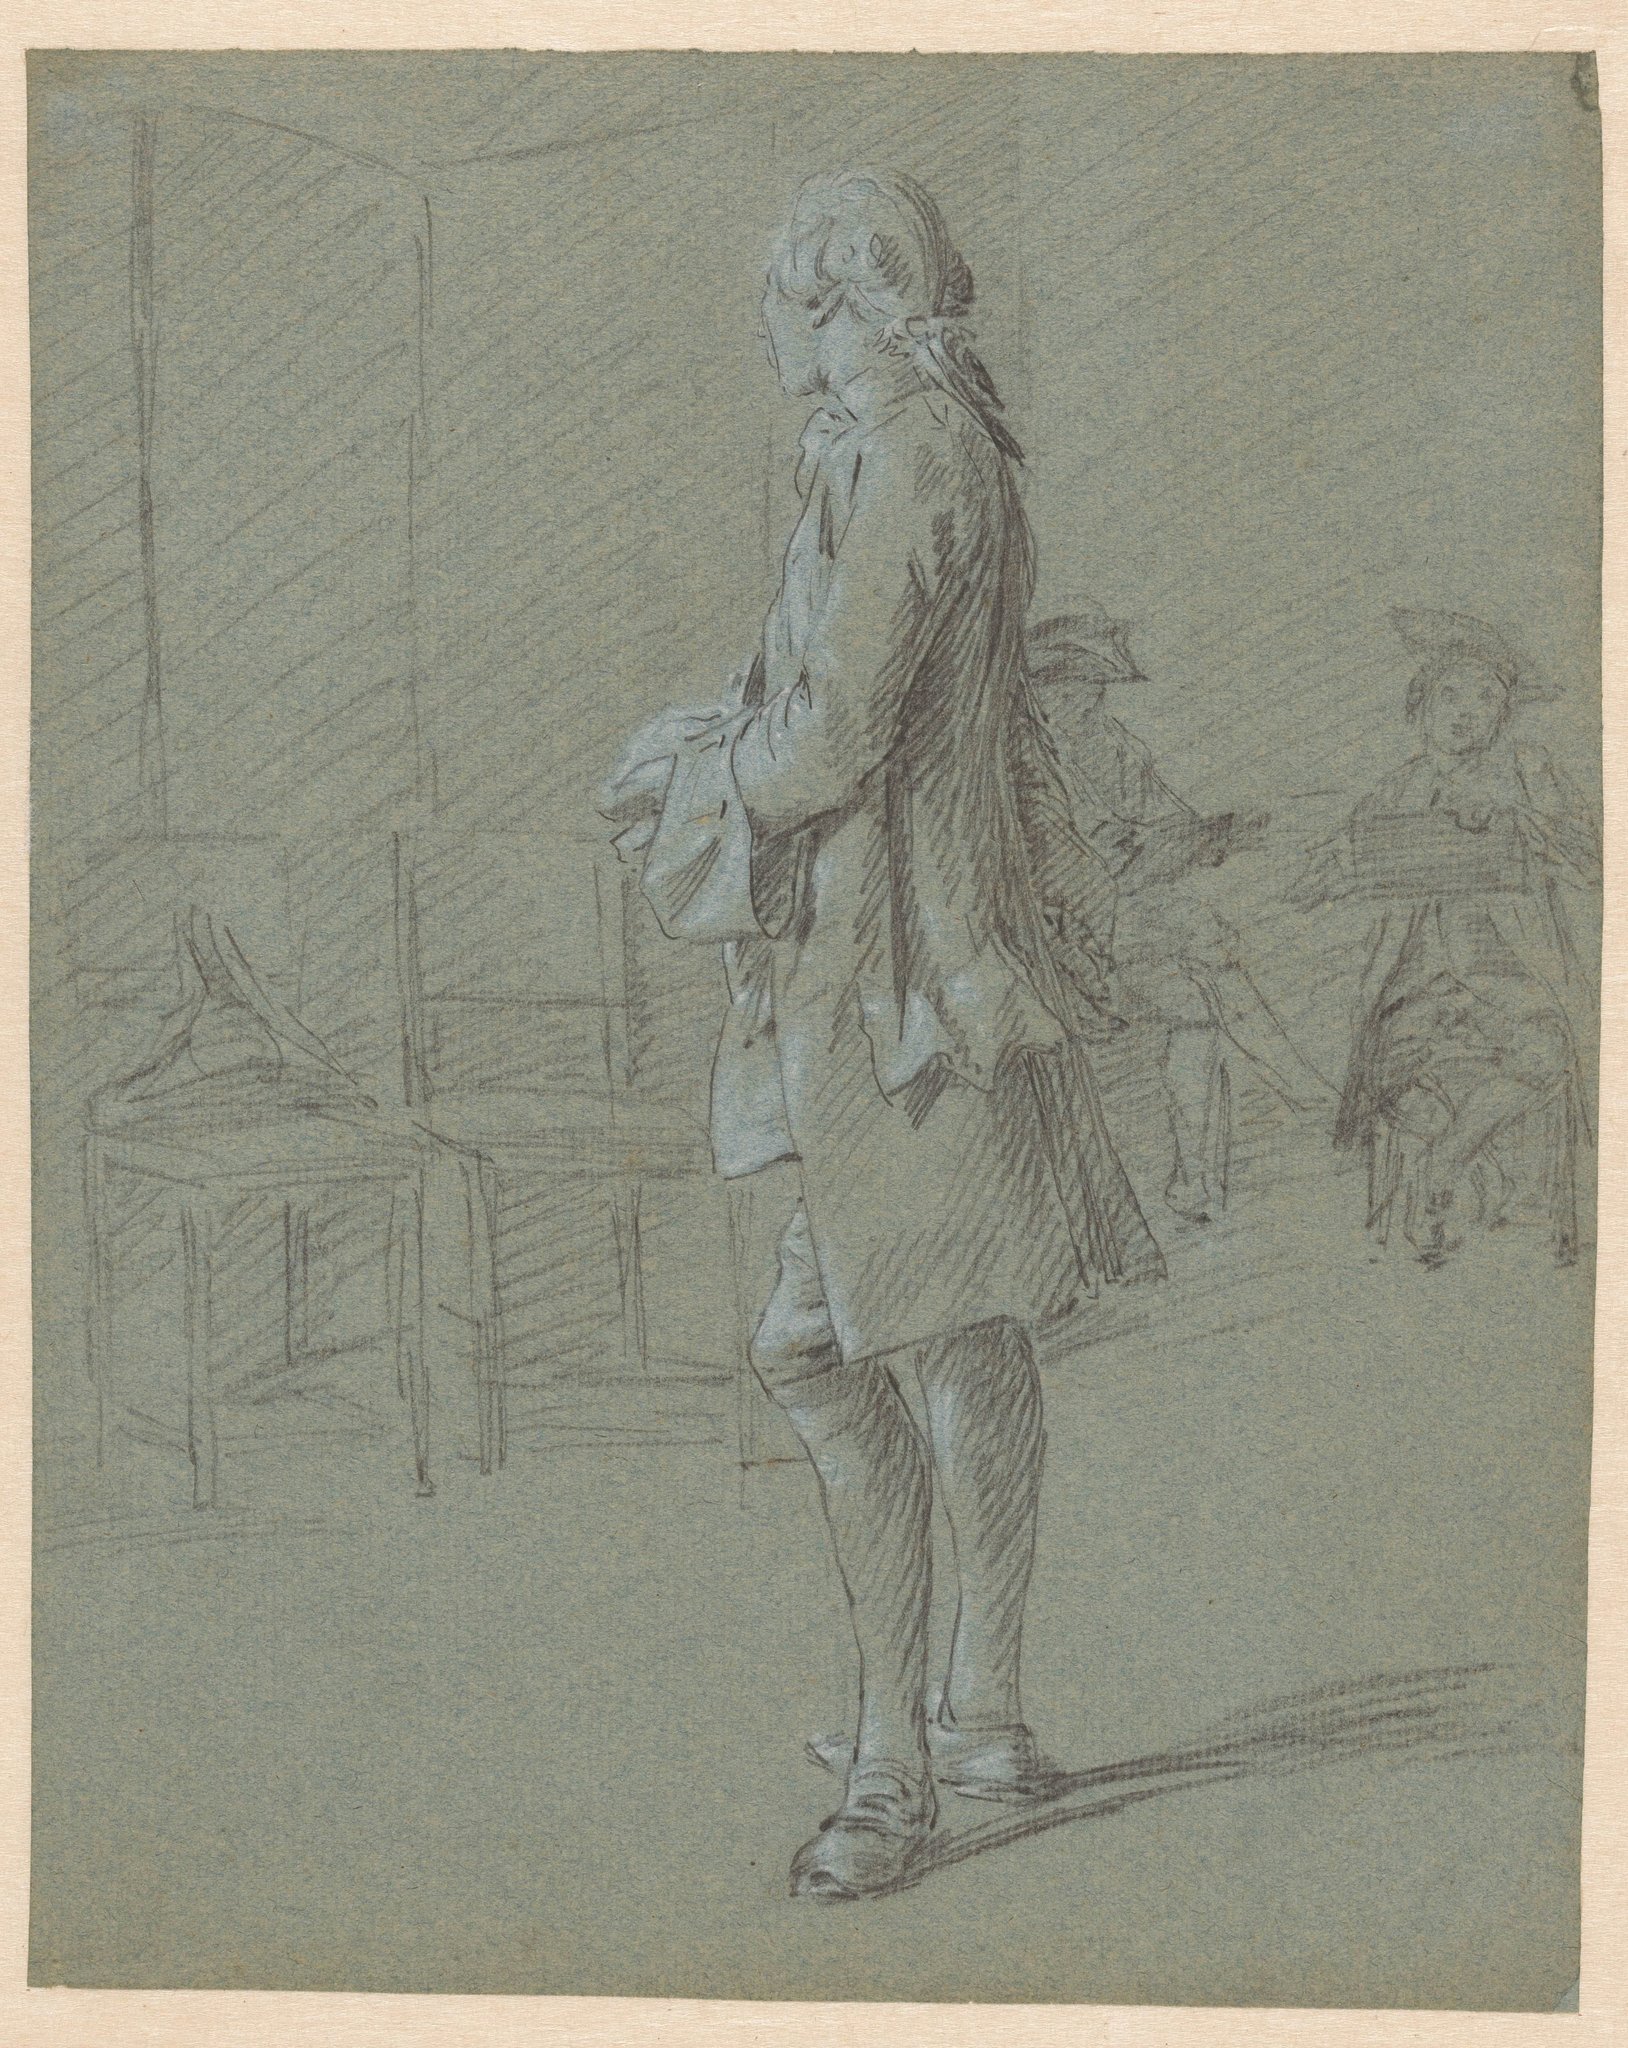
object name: drawing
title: Zittende man in lange jas met pijp in de hand, naar rechts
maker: gerrit zegelaar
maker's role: draughtsman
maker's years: 1719-1994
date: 1729-1794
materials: chalk, paper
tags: circle, club of artists, postures of the human figure, place or institution of education and training of the artist, e.g.: academy of art, artist (in general) working from clothed model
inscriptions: inscription: ‘studie van een staande man met in de hand een tang met een kooltje vuur, waaraan hij een sigaar aansteekt [??]’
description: Zittende man in lange jas met pijp in de rechterhand, naar rechts. Opschrift links midden: 4 voet 10 duym. Rechtsonder: N:8